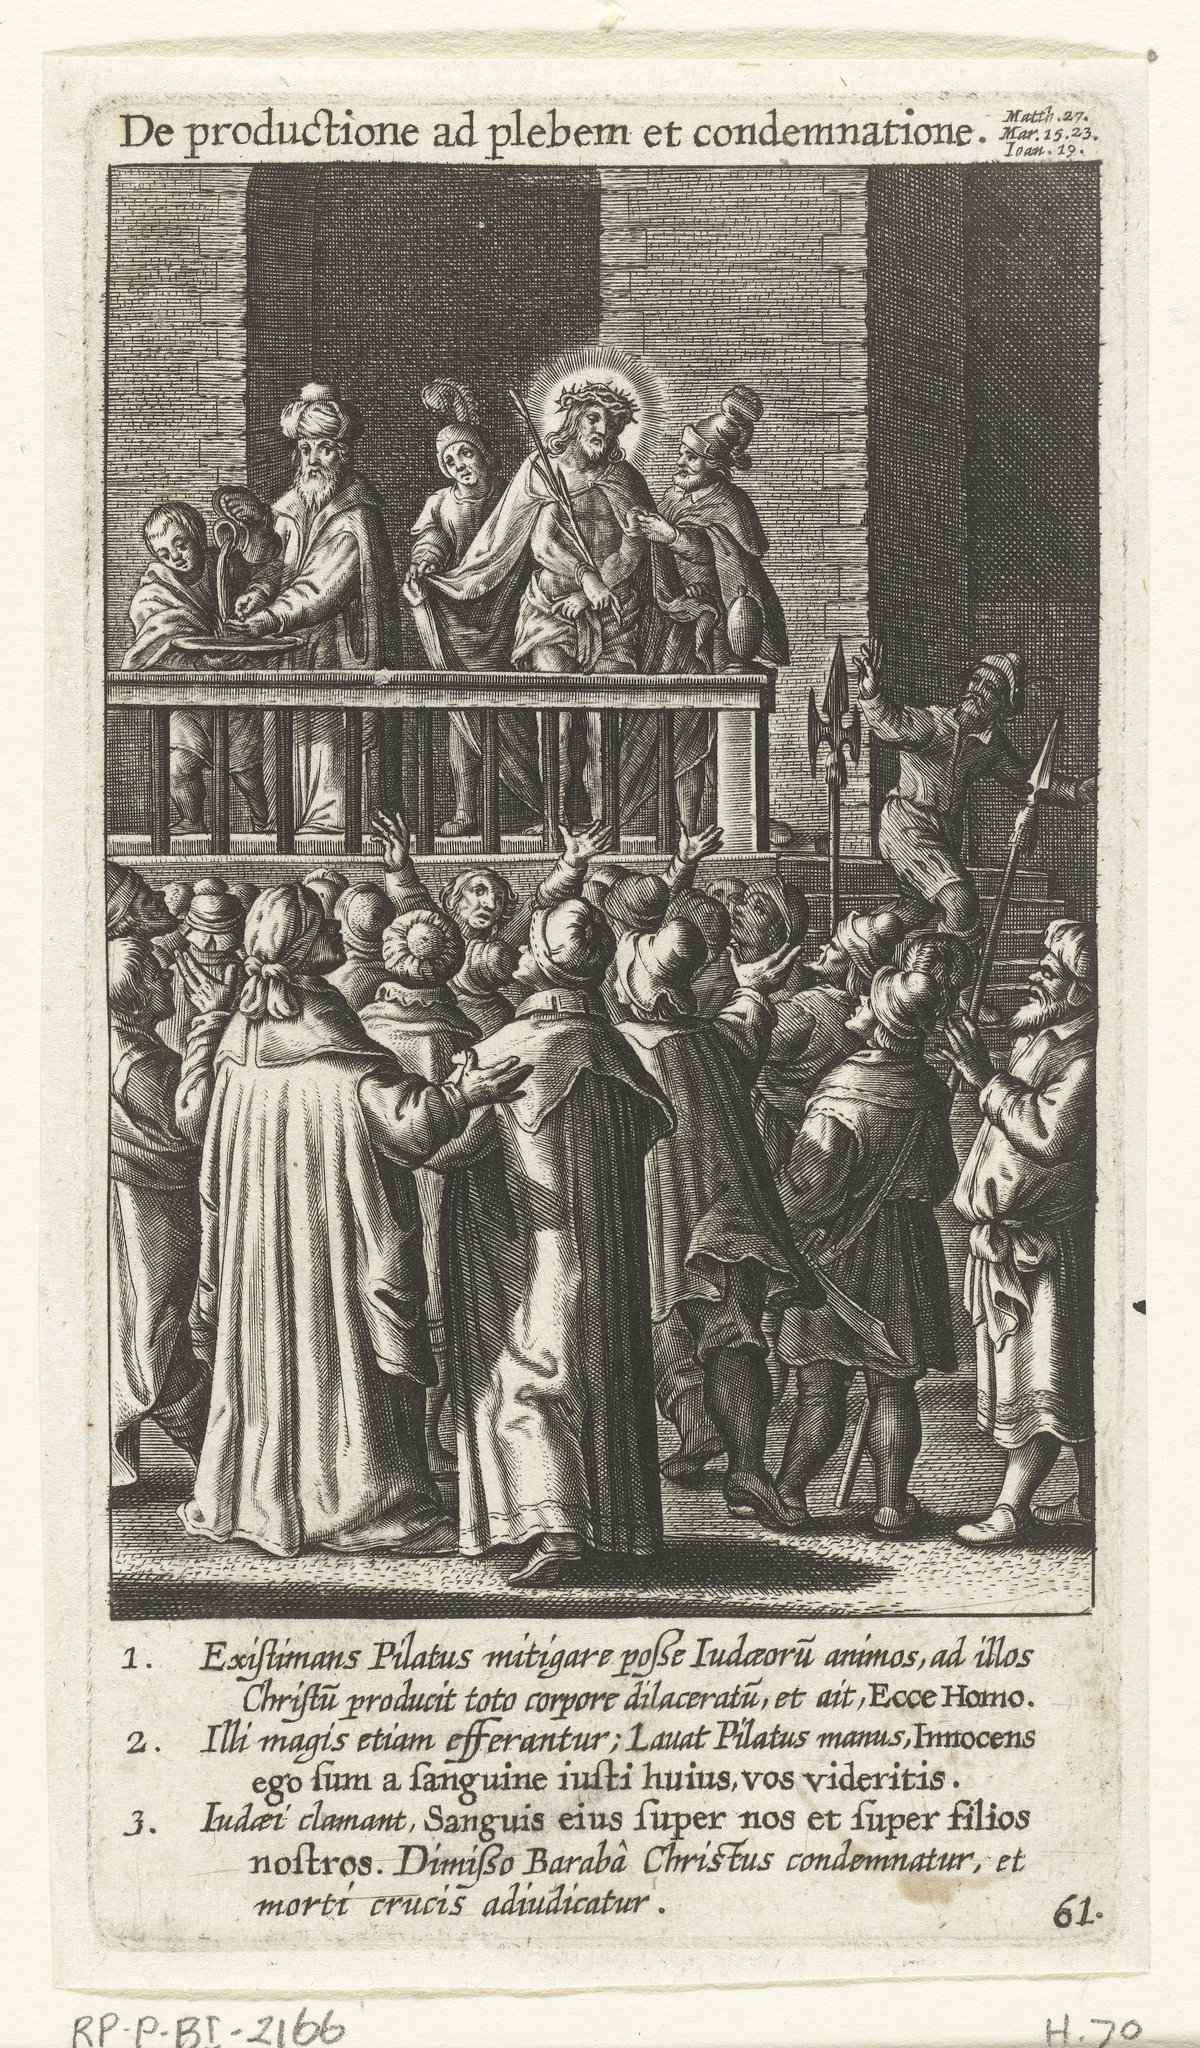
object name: book illustration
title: Ecce Homo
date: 1590-1622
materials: paper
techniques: engraving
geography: antwerp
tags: pilate showing christ to the people, 'ostentatio christi', 'ecce homo' (john 19:4-6)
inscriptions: collector's mark: Lugt 240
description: Prent uit: Joannes Bourgois, Vitae passionis et mortis Jesu Christi Somini nostri mysteria, Antwerpen Hendrick Aertssens, 1622, afb. 61